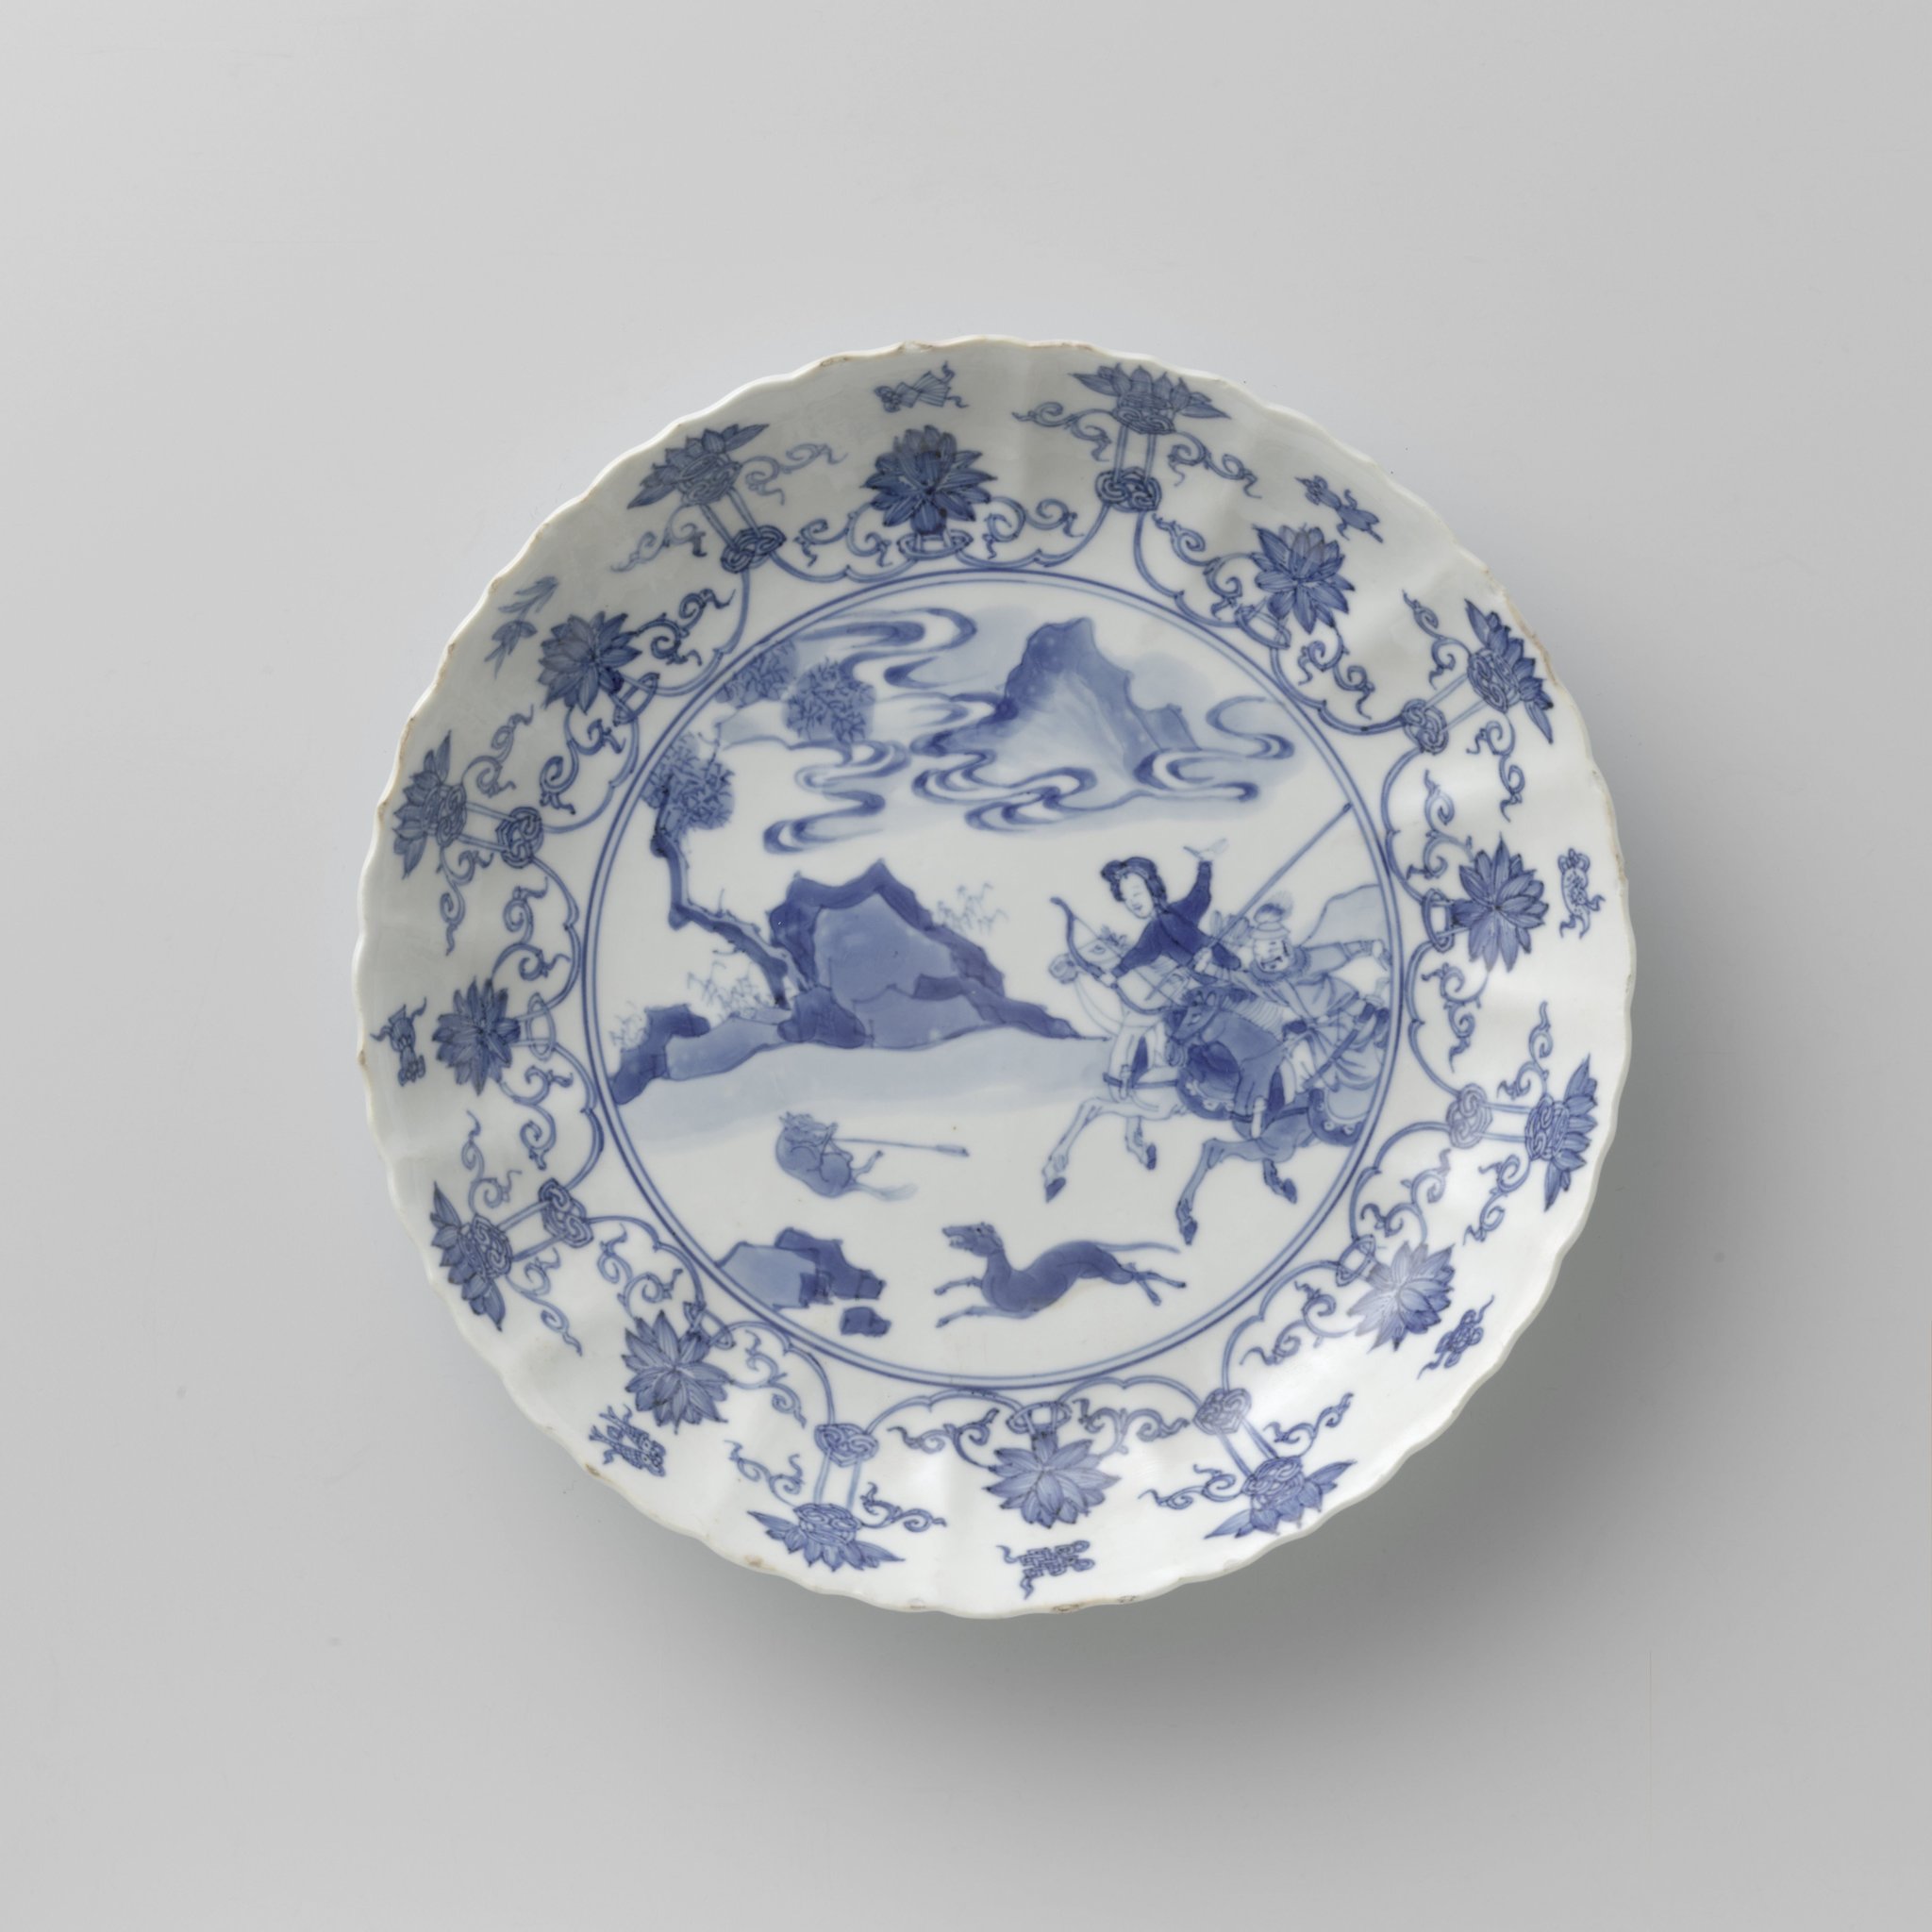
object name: dish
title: Saucer-dish with hunting scene, lotus scrolls and auspicious symbols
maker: Anonymous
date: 1700-1724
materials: cobalt, glaze, paint, porcelain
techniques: firing, forming, turning, vitrification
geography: china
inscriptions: mark: ‘大 明 成 化 年 製 dà míng Chéng huà nián zhì’